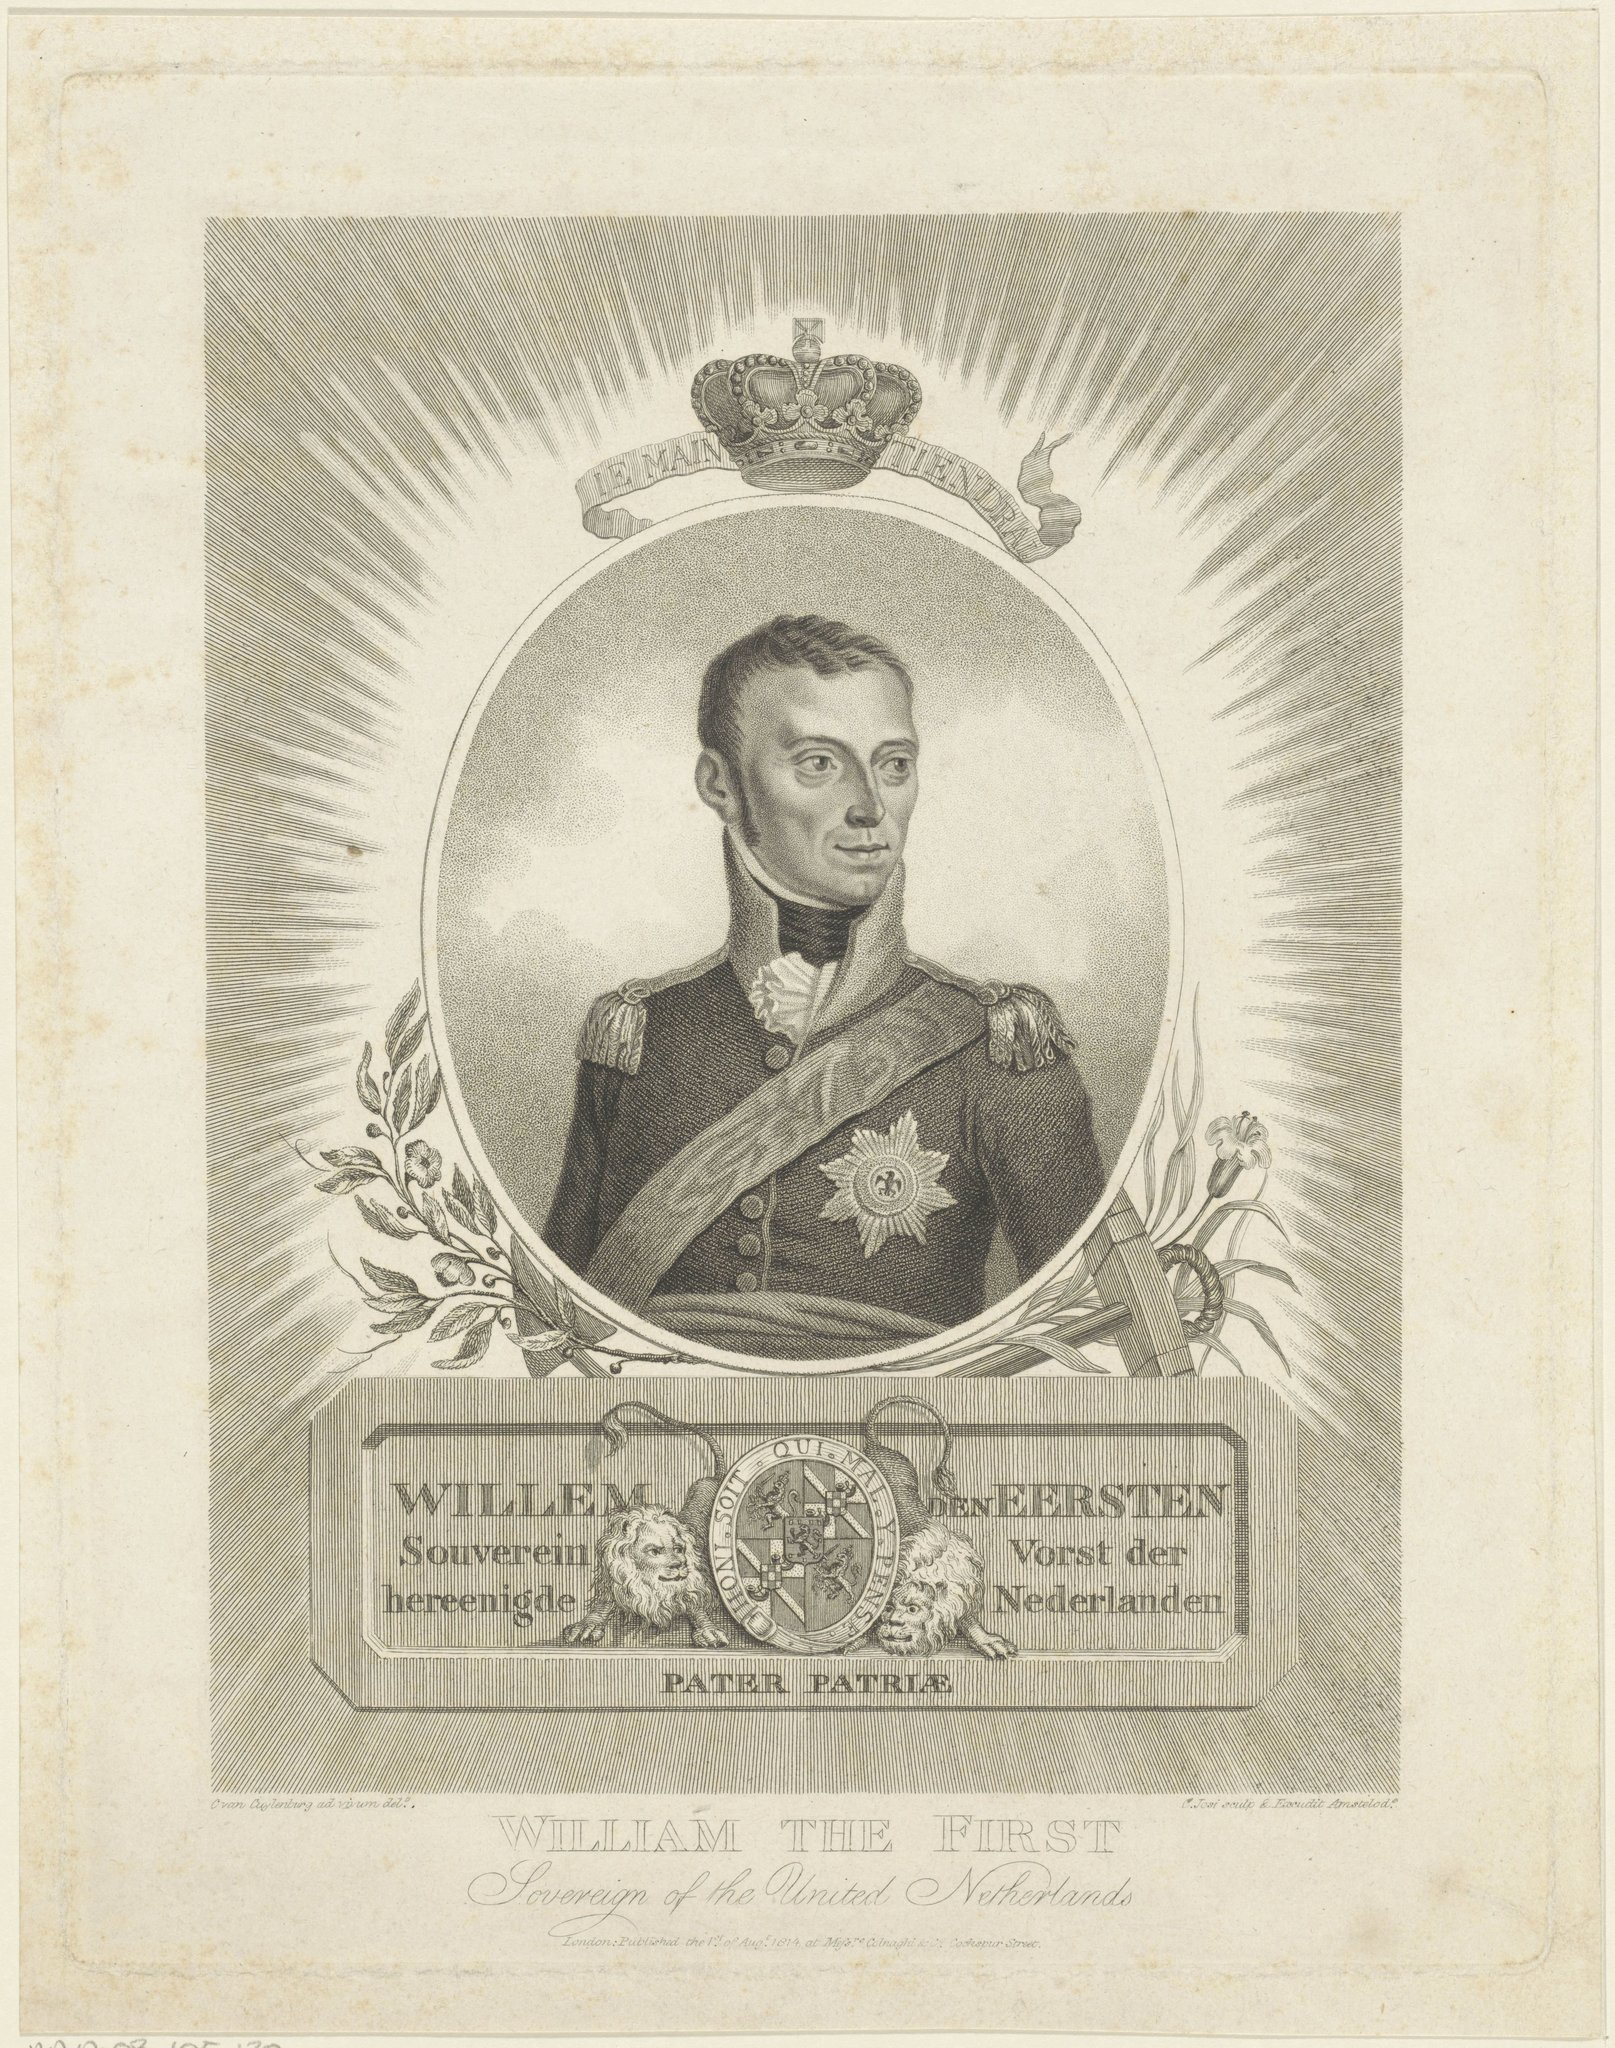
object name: print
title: Portret van Willem I Frederik, koning der Nederlanden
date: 1814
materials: paper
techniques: engraving, etching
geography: amsterdam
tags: the hague, berlin, william i of the netherlands, knighthood order (garter) - insignia of a knighthood order, e.g.: badge, chain, knighthood order (with name) - insignia of a knighthood order, e.g.: badge, chain (with name of order)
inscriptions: date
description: Portret van Willem I Frederik in een ovaal. Daar omheen een aantal allegorische objecten. Midden boven een kroon en op een banderol zijn geslachtsspreuk. Op een voetstuk zijn wapen met twee leeuwen, gedecoreerd met de Kousenband en het devies van de Orde van de Kousenband, zijn naam en zijn titel in het Nederlands. In de ondermarge zijn naam en titel in het Engels.